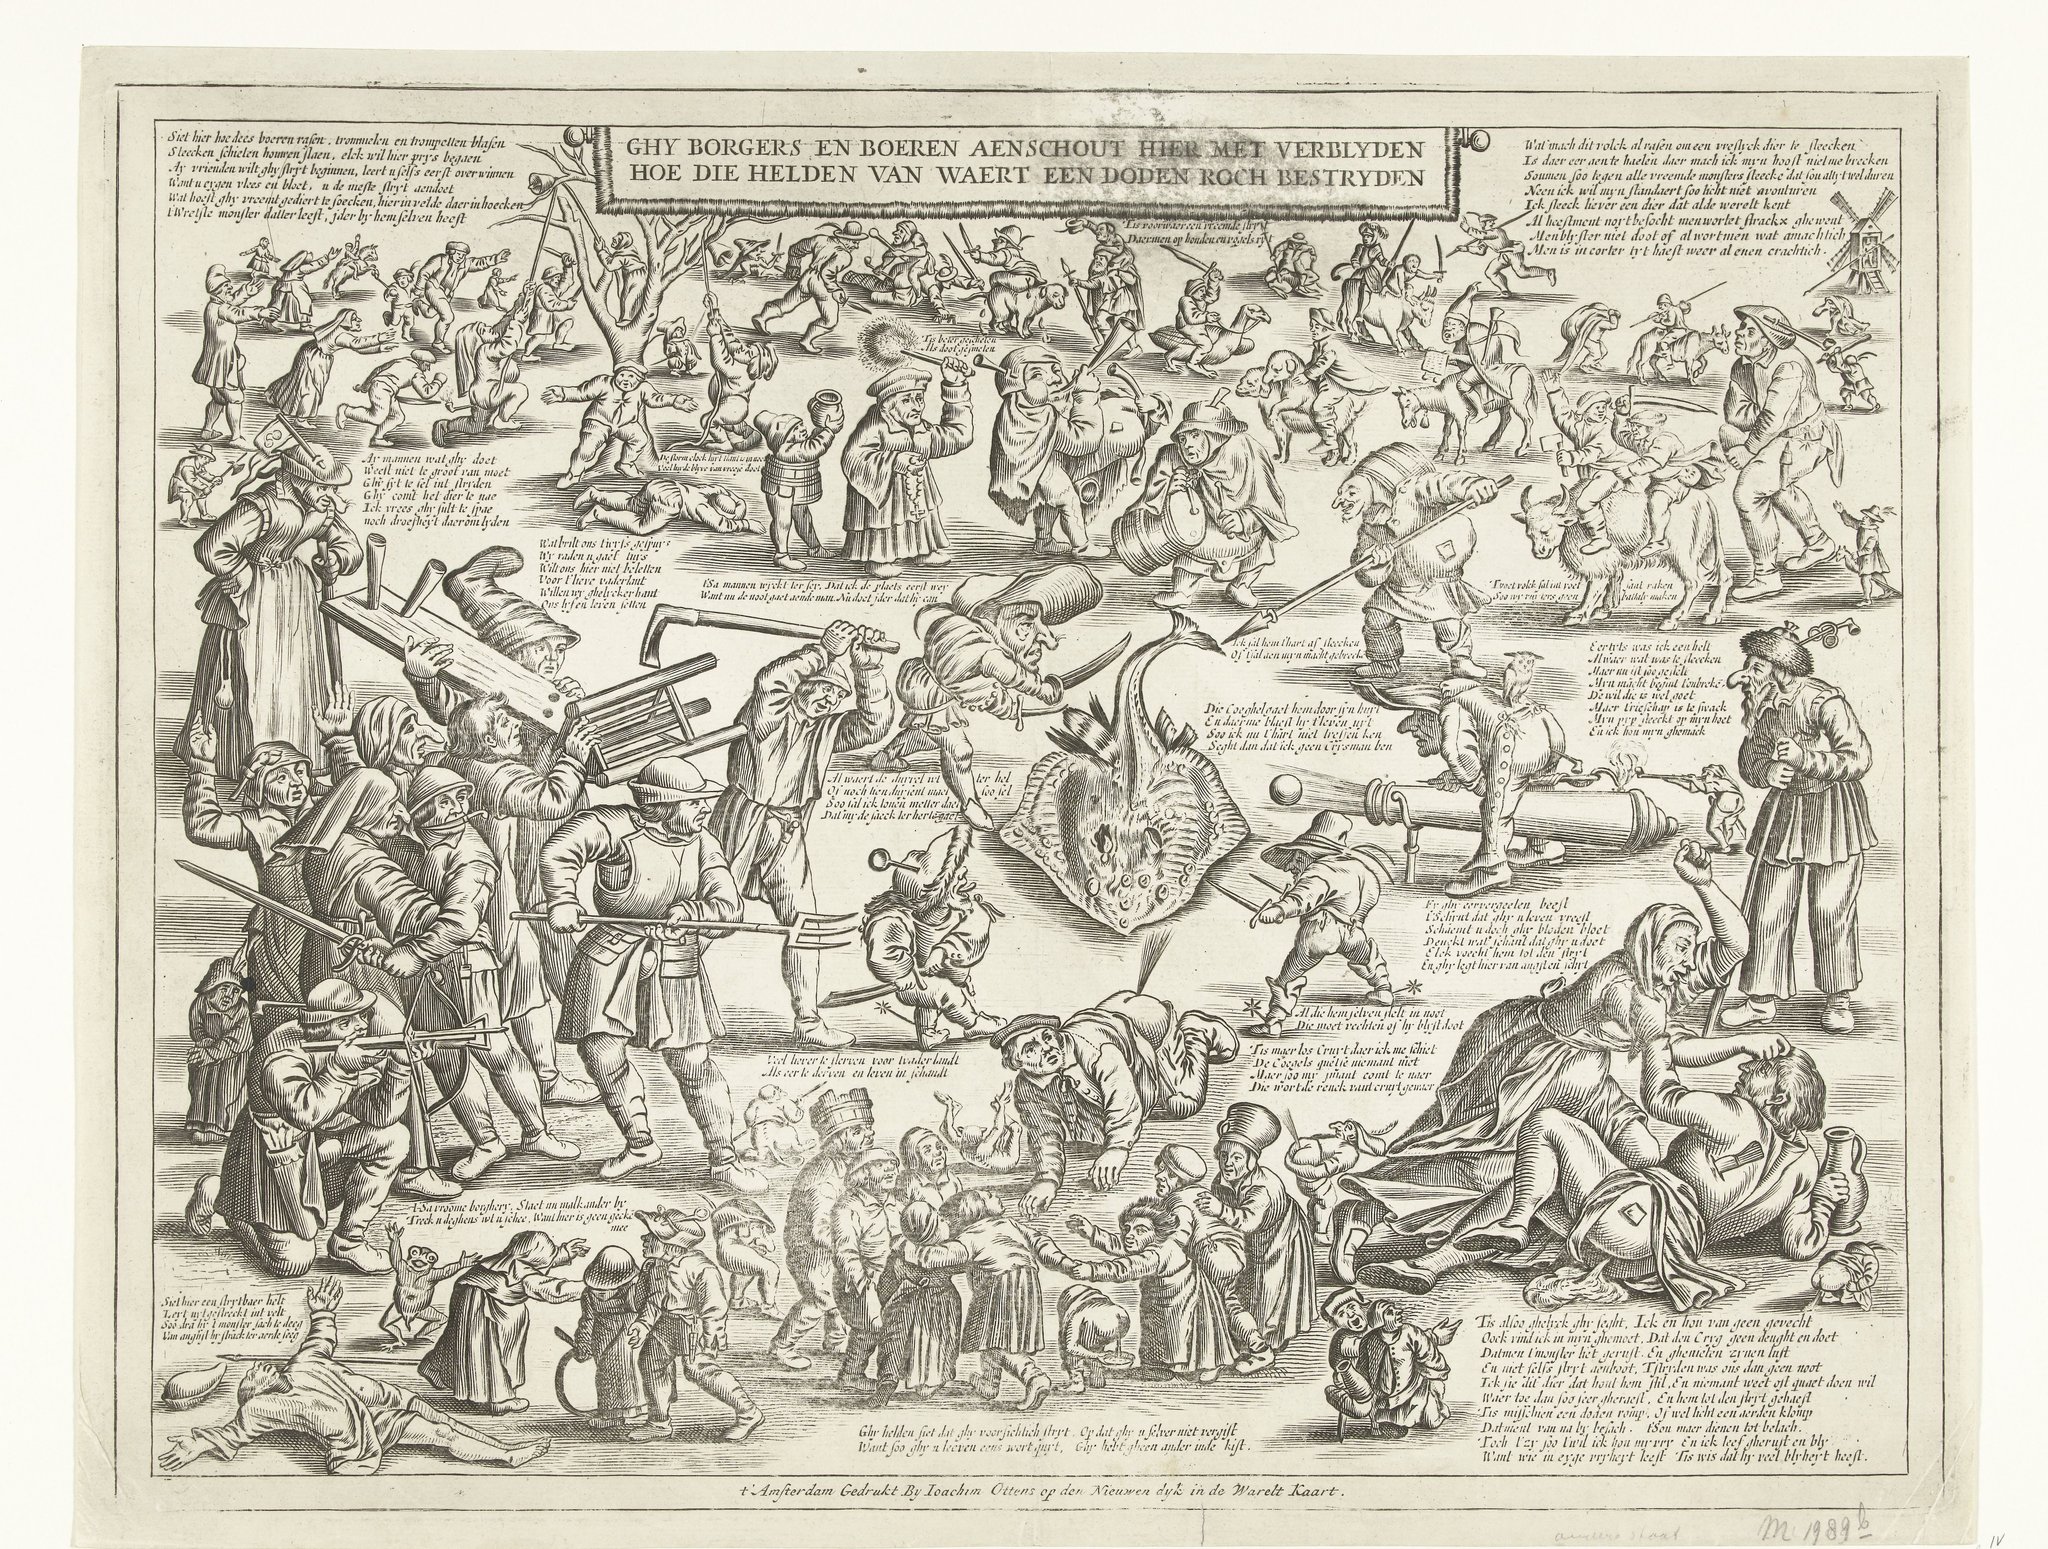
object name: cartoon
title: De Rogstekers van Weert, ca. 1650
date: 1675-1720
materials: paper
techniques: engraving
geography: northern netherlands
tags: caricatures (human types)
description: De Rogstekers van Weert, ca. 1650. Spotprent waarin allerlei verschillende dwazen in het plaatsje Waert (Weert in Limburg) ten strijde trekken tegen (het denkbeeldige gevaar van) een dode rog. In het midden een grote rog, waarop een kanon wordt afgevuurd. Rechtsachter een molen; linksachter een boom waaraan een klok die wordt geluid. Over het hele blad talloze figuren met verschillende attributen en verklarende teksten. In drie hoeken langere verzen.